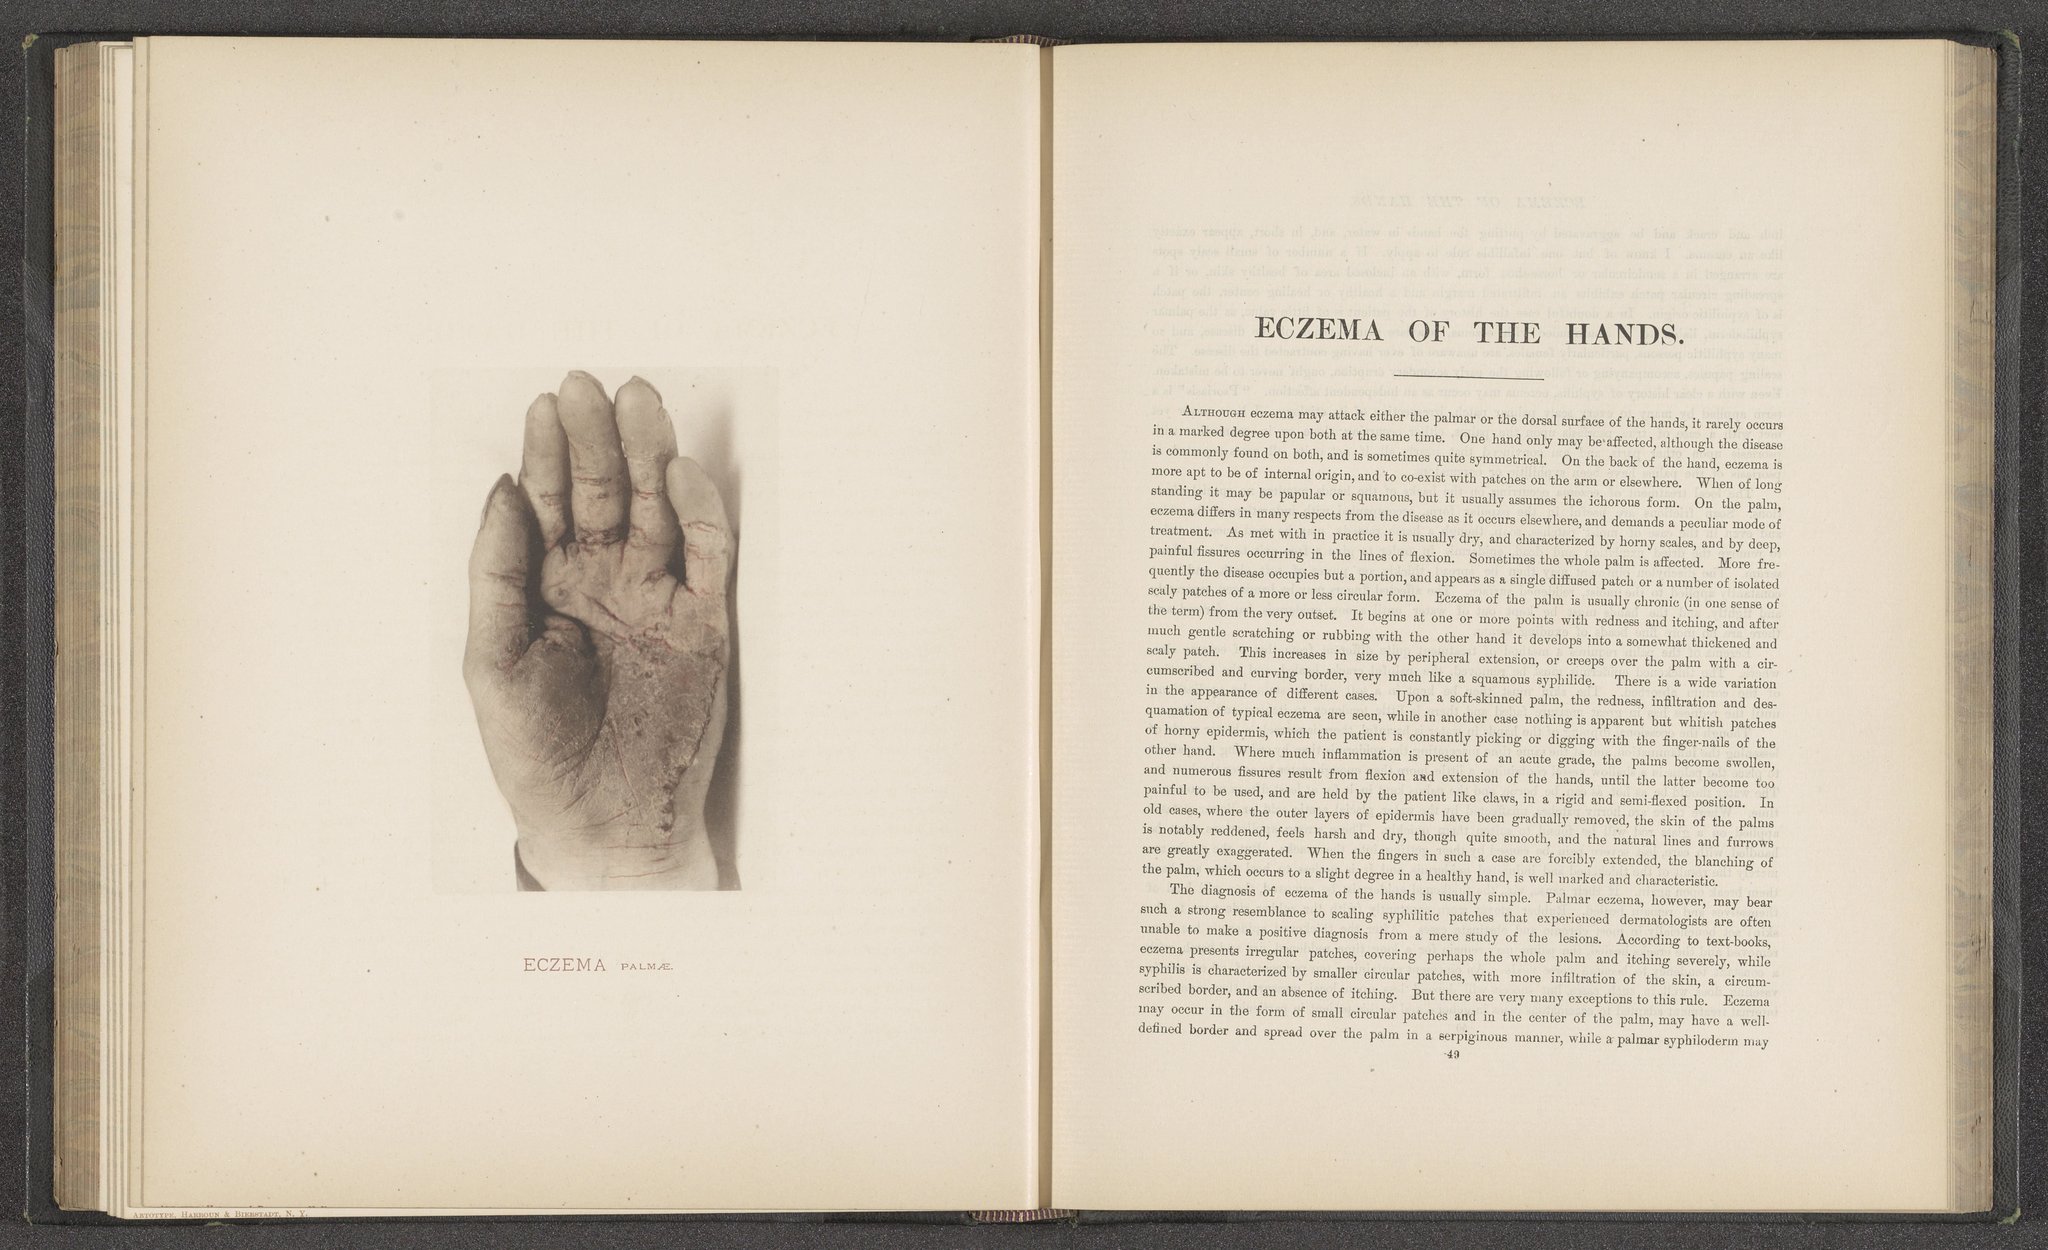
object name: page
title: Patiënt lijdend aan de huidziekte 'eczema palmae'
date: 1870-1881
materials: paper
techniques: photograph, hand coloring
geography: new york city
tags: skin and venereal diseases, adult man, beard